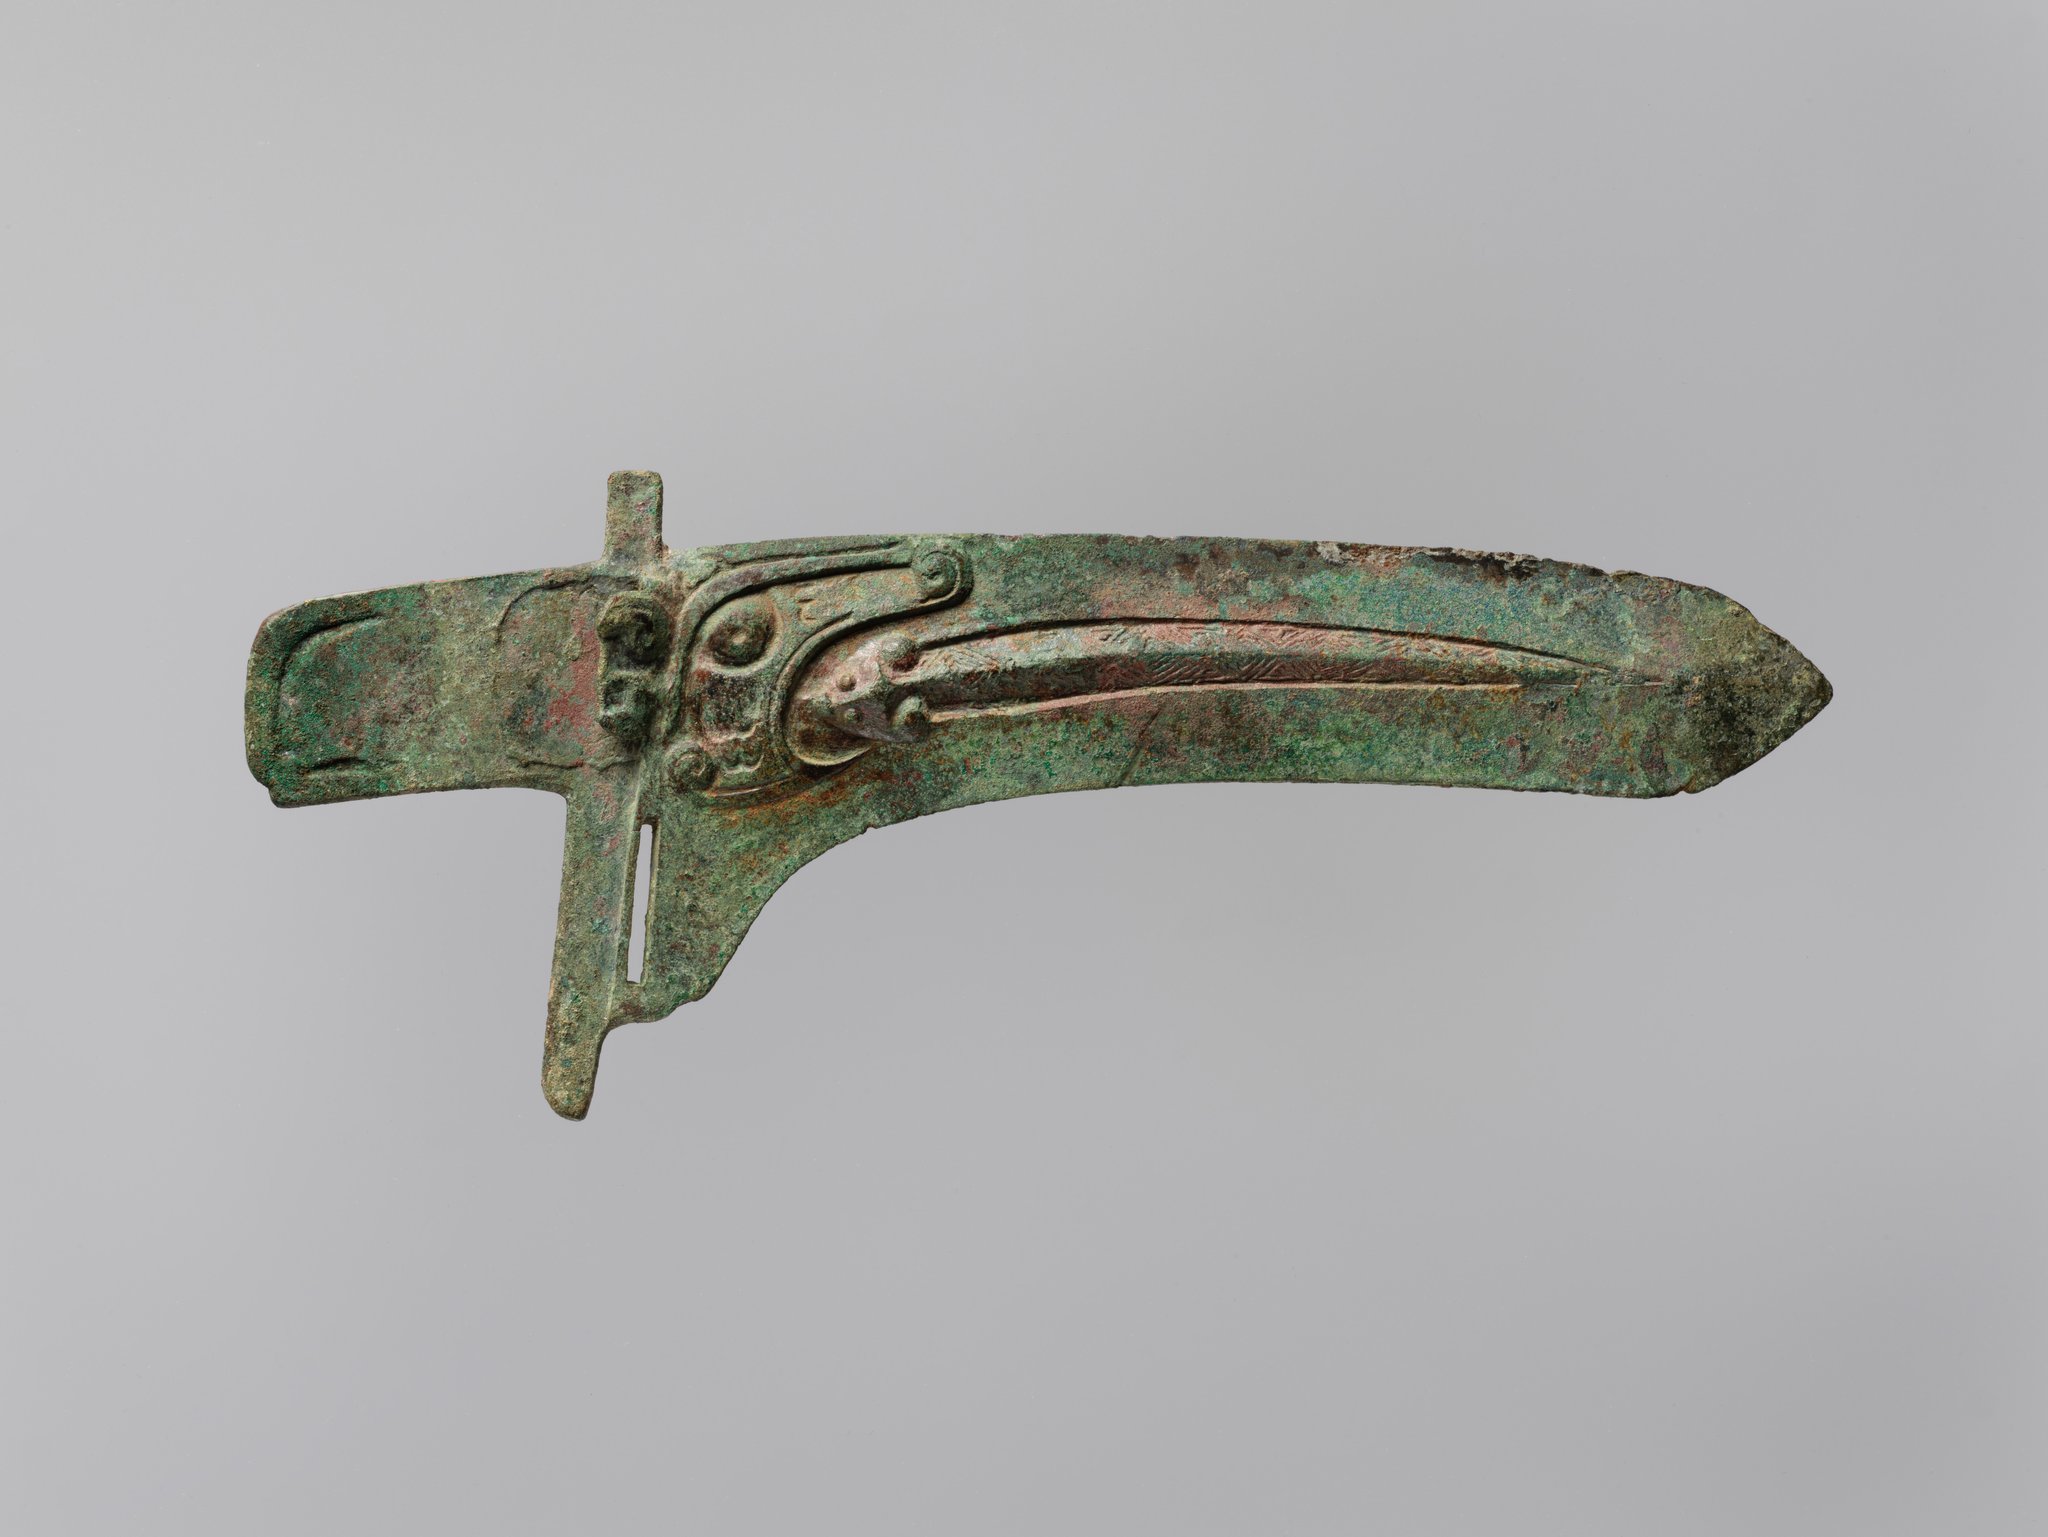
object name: dagger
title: Dagger-Axe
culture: chinese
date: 1000-801 BCE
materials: bronze